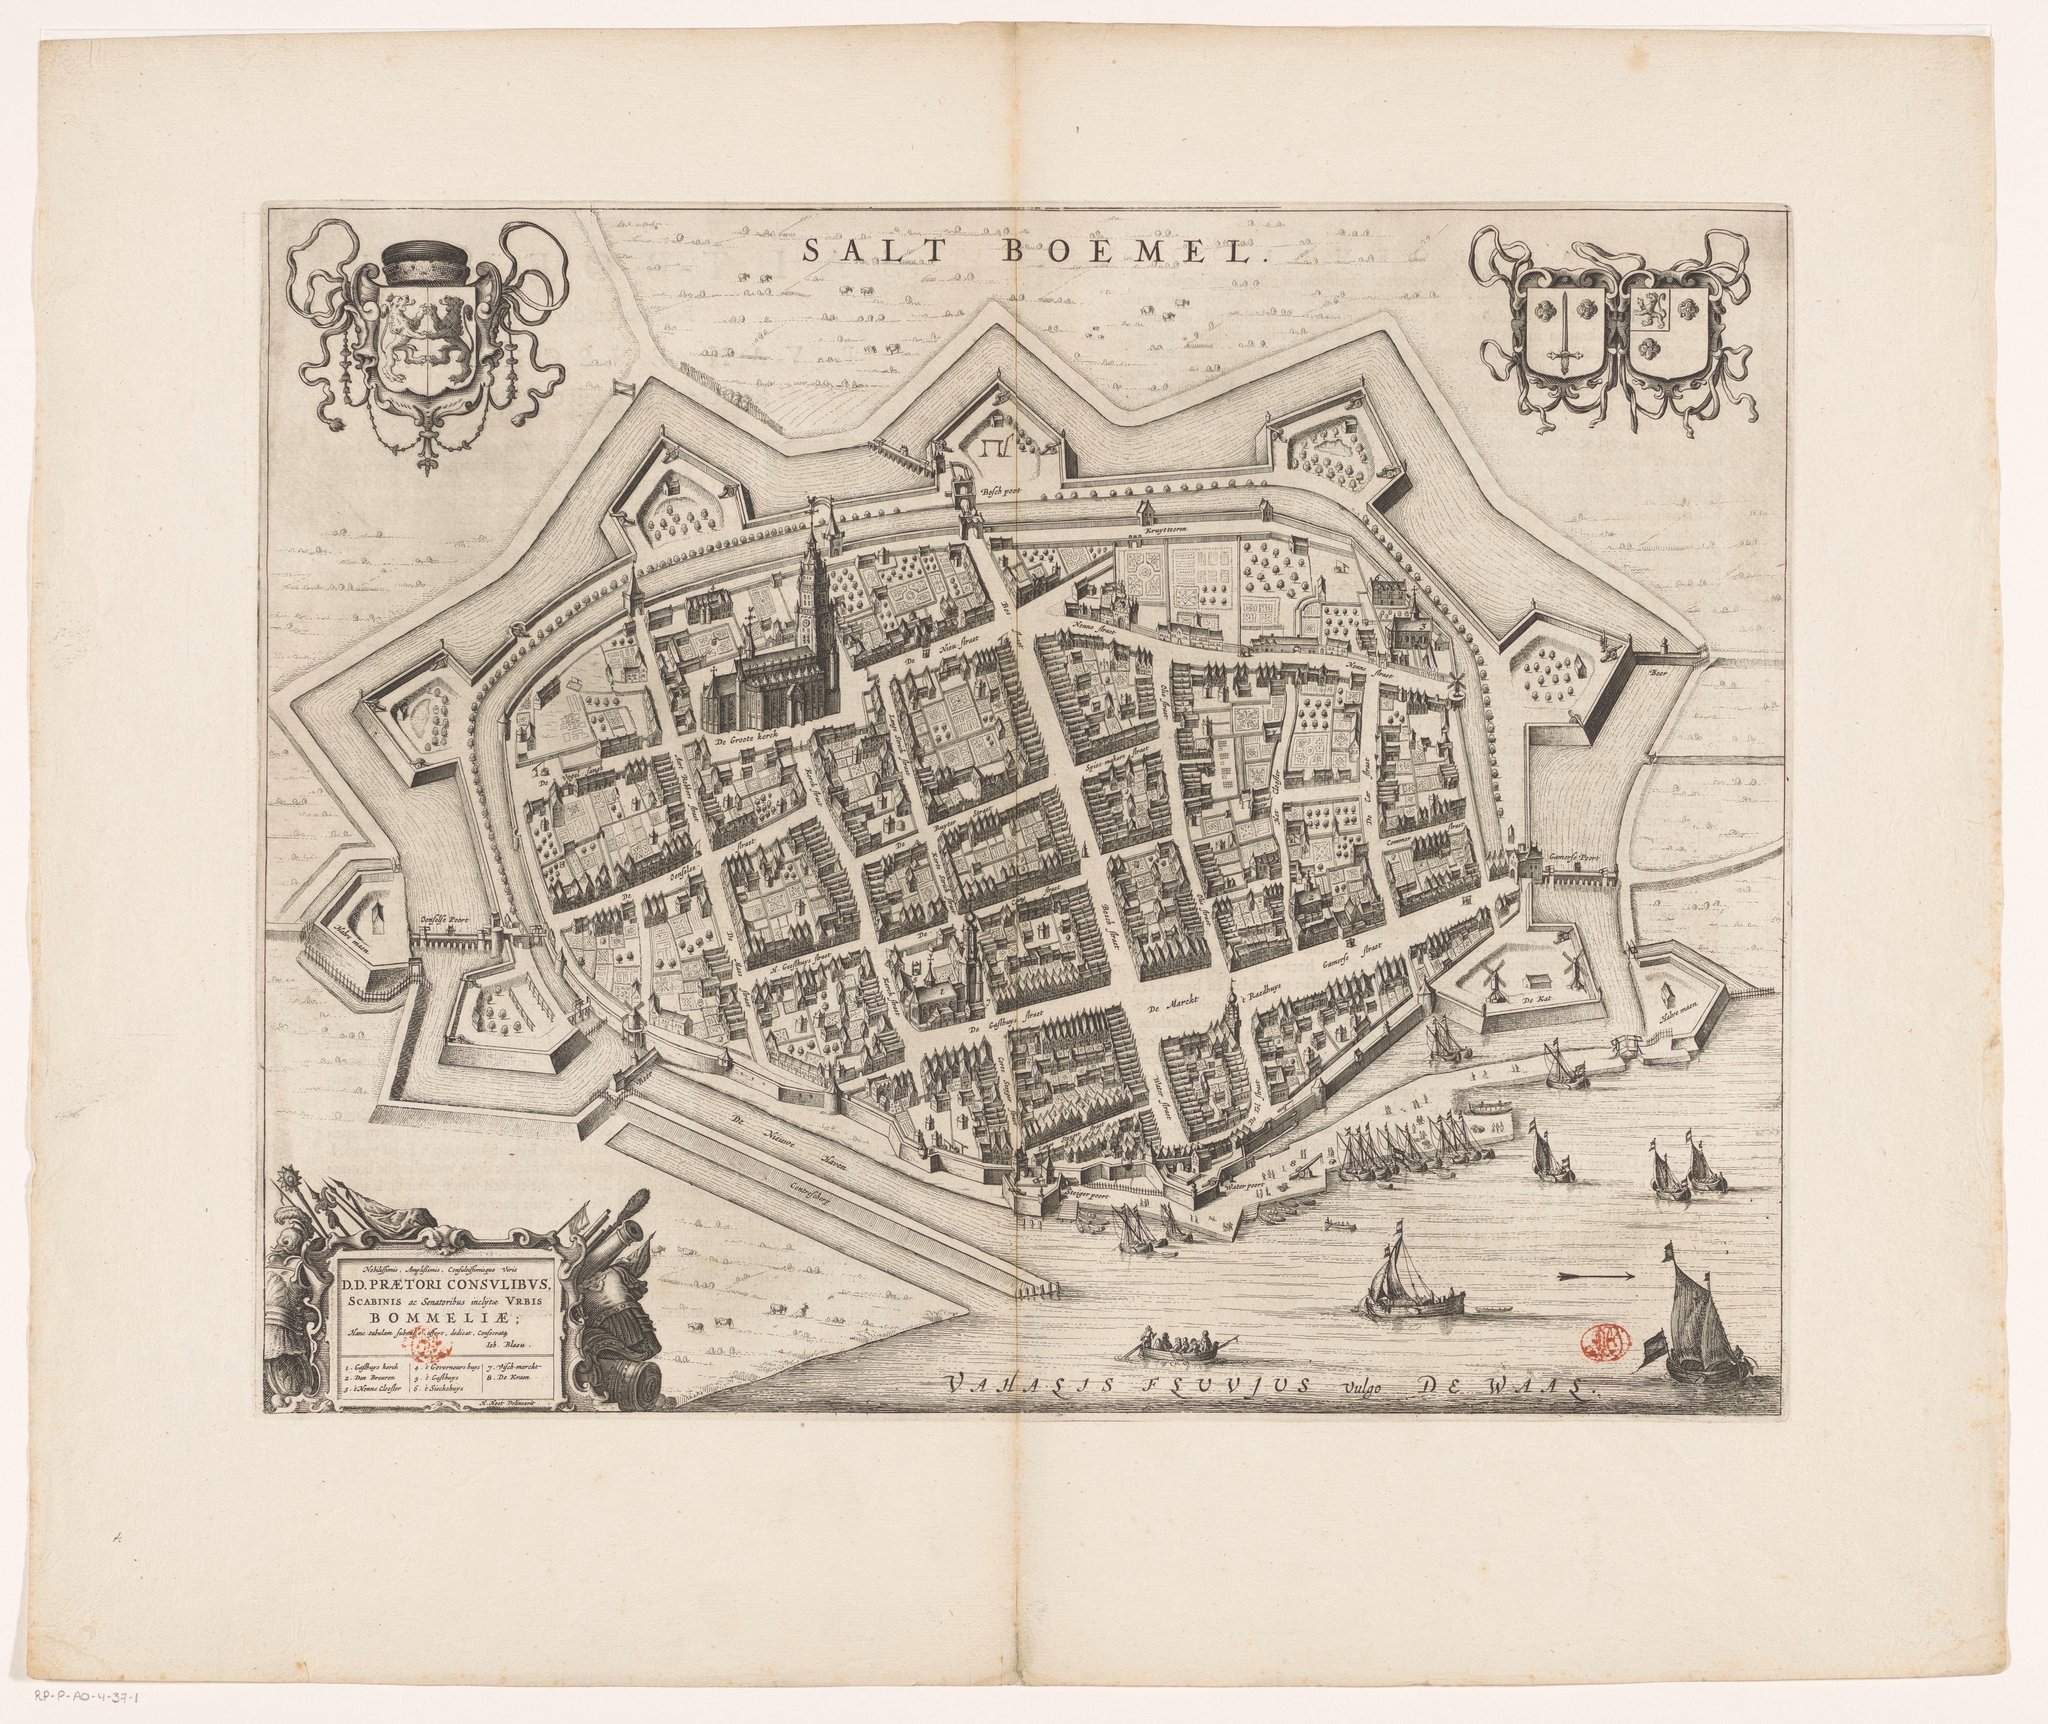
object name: area plan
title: Salt Boemel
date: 1652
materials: paper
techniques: engraving, etching, letterpress printing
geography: amsterdam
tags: coat of arms (as symbol of the state, etc.), maps of cities, gelderland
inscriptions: collector's mark: Lugt 195, collector's mark: Lugt 2233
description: Plattegrond in vogelvluchtperspectief. Linksboven het wapen van Gelderland. Linksonder de opdracht met daaronder de legenda. Rechtsboven twee wapens van Zaltbommel. Op verso Nederlandse tekst.